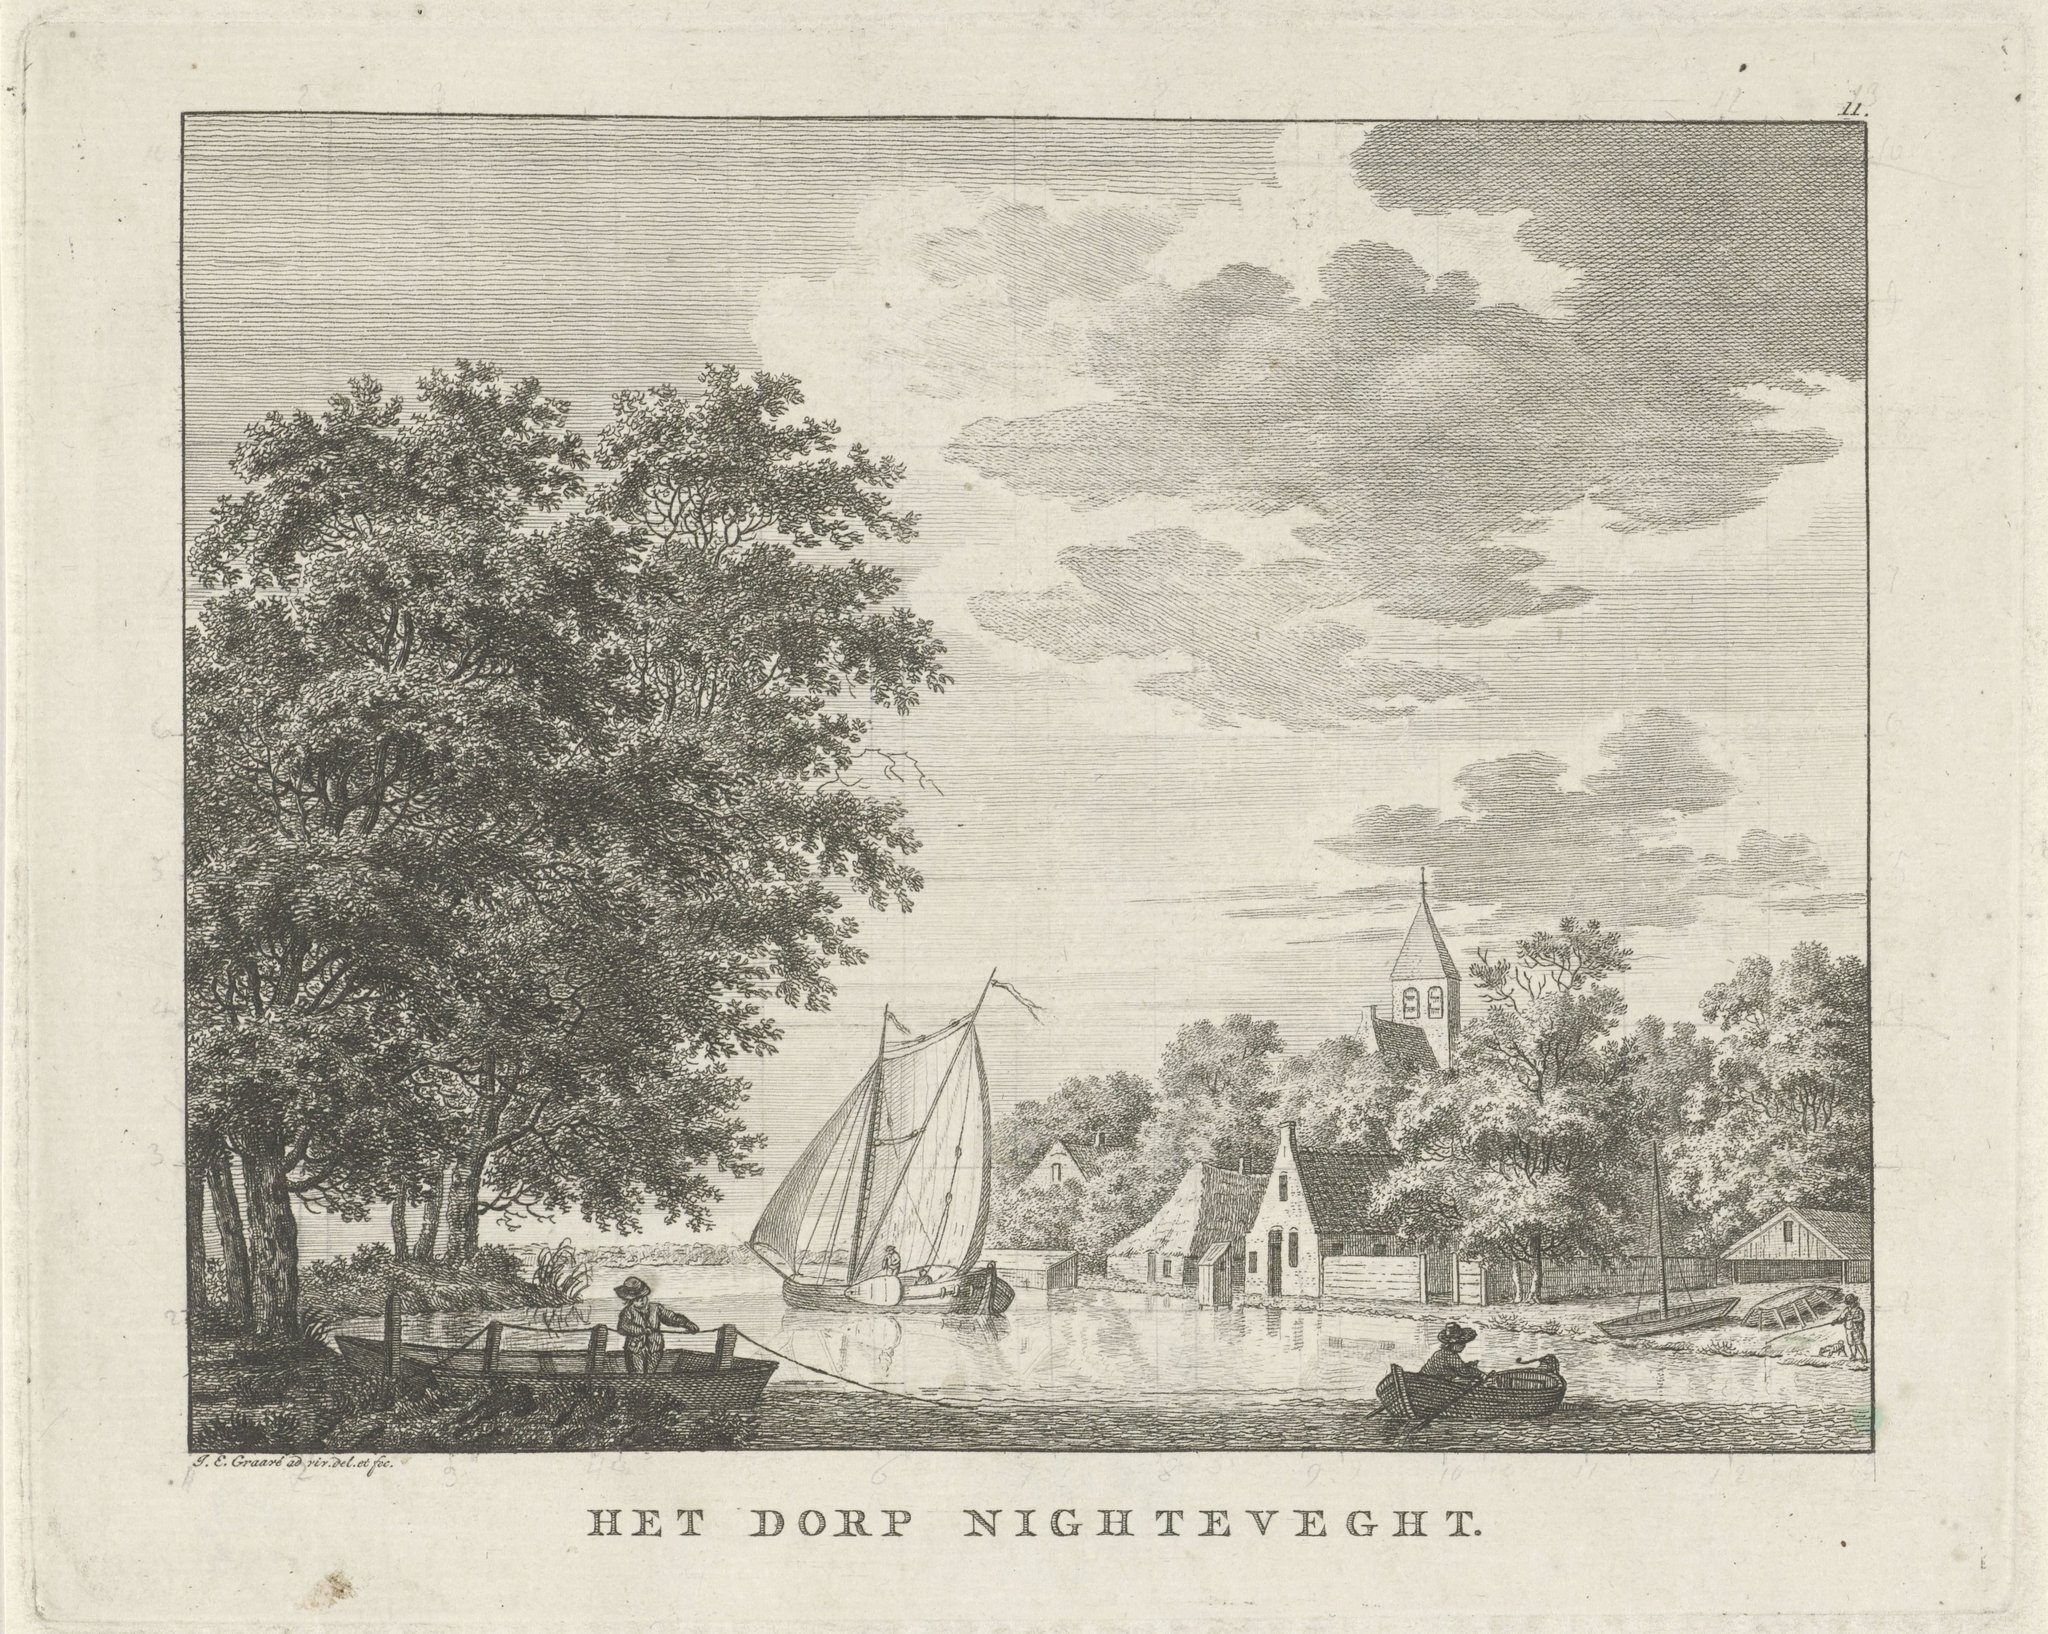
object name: print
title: Nederlandse dorpen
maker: jan evert grave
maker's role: draughtsman, print maker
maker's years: 1759-1805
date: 1786-1805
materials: paper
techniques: engraving, etching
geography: amsterdam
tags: river (+ landscape with figures, staffage)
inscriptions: collector's mark: Lugt 2228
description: Het dorp Nigtevecht. Op de voorgrond een rivier. Op de achtergrond de kerktoren. De prent maakt deel uit van een serie met Nederlandse dorpen.